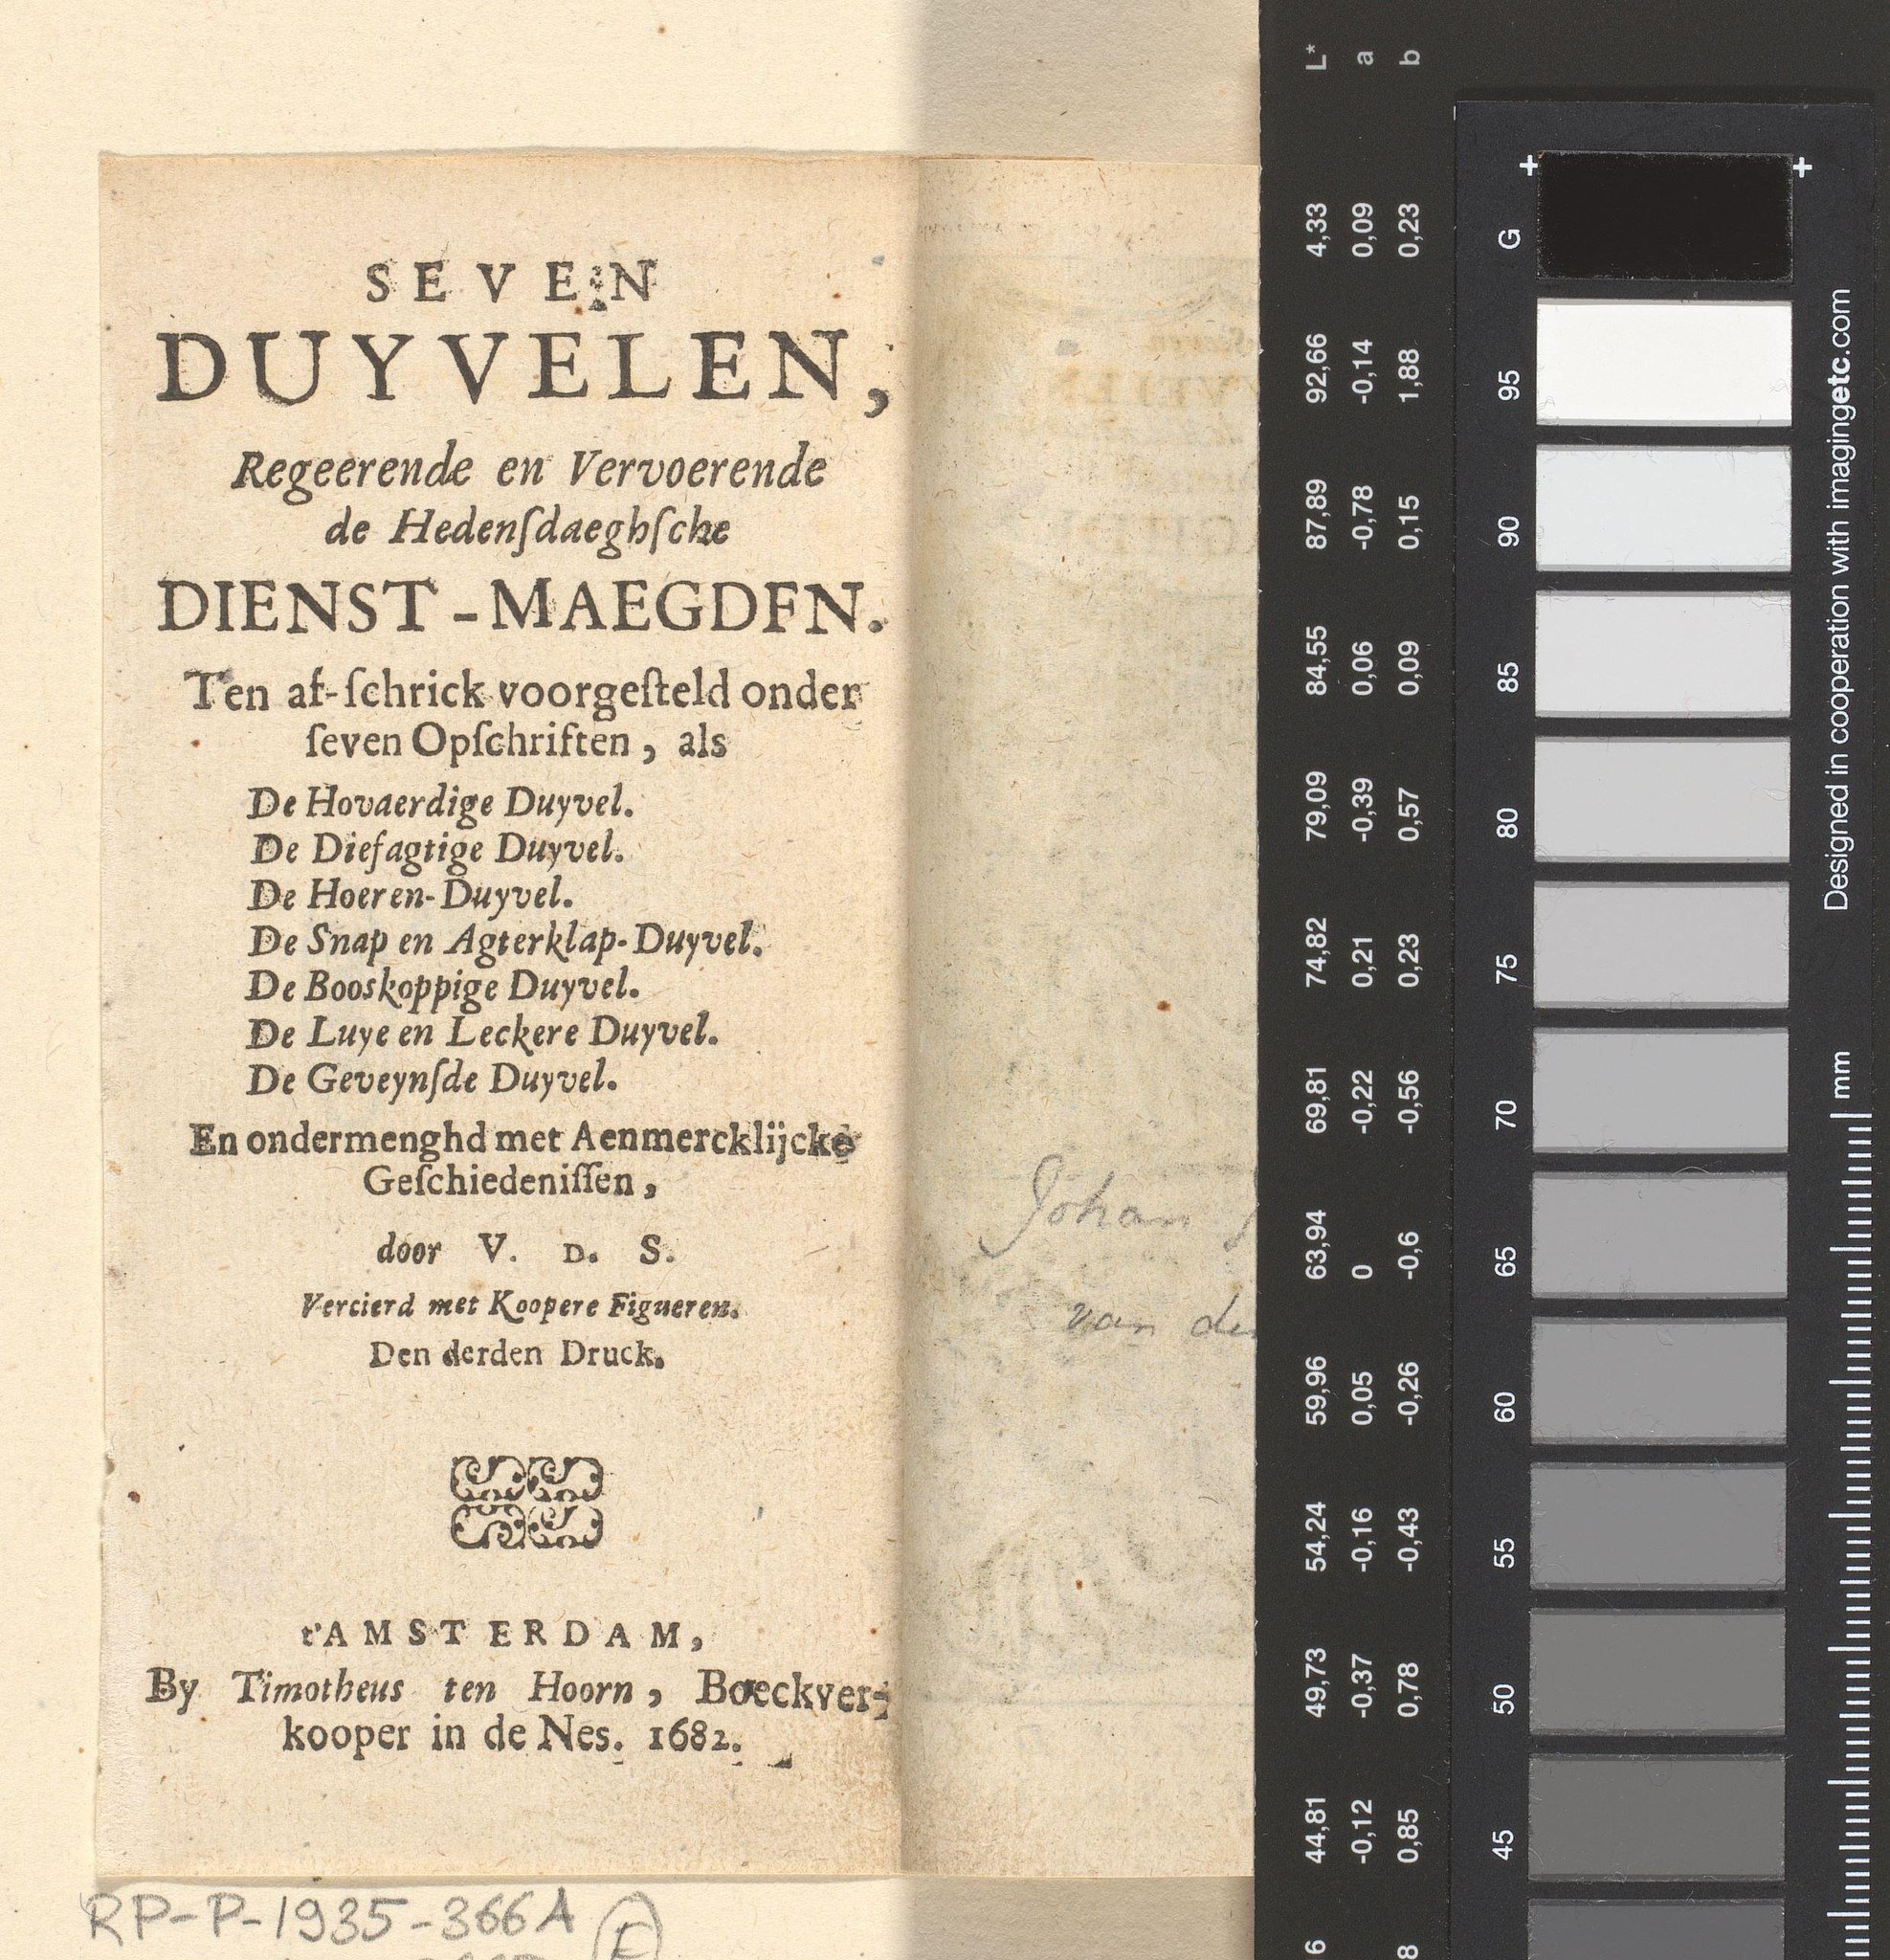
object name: print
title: Titelpagina voor Simon de Vries, Seven Duyvelen regeerende en serveerende de Hedendaeghsche Dienstmaegden, Amsterdam, 1682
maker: timotheus ten hoorn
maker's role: bookseller, publisher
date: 1682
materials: paper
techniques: letterpress printing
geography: amsterdam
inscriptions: collector's mark: Lugt 2760, collector's mark: Lugt 2228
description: uit: Simon de Vries, Seven Duyvelen regeerende en serveerende de Hedendaeghsche Dienstmaegden, Amsterdam, Timotheus ten Hoorn, 1682.